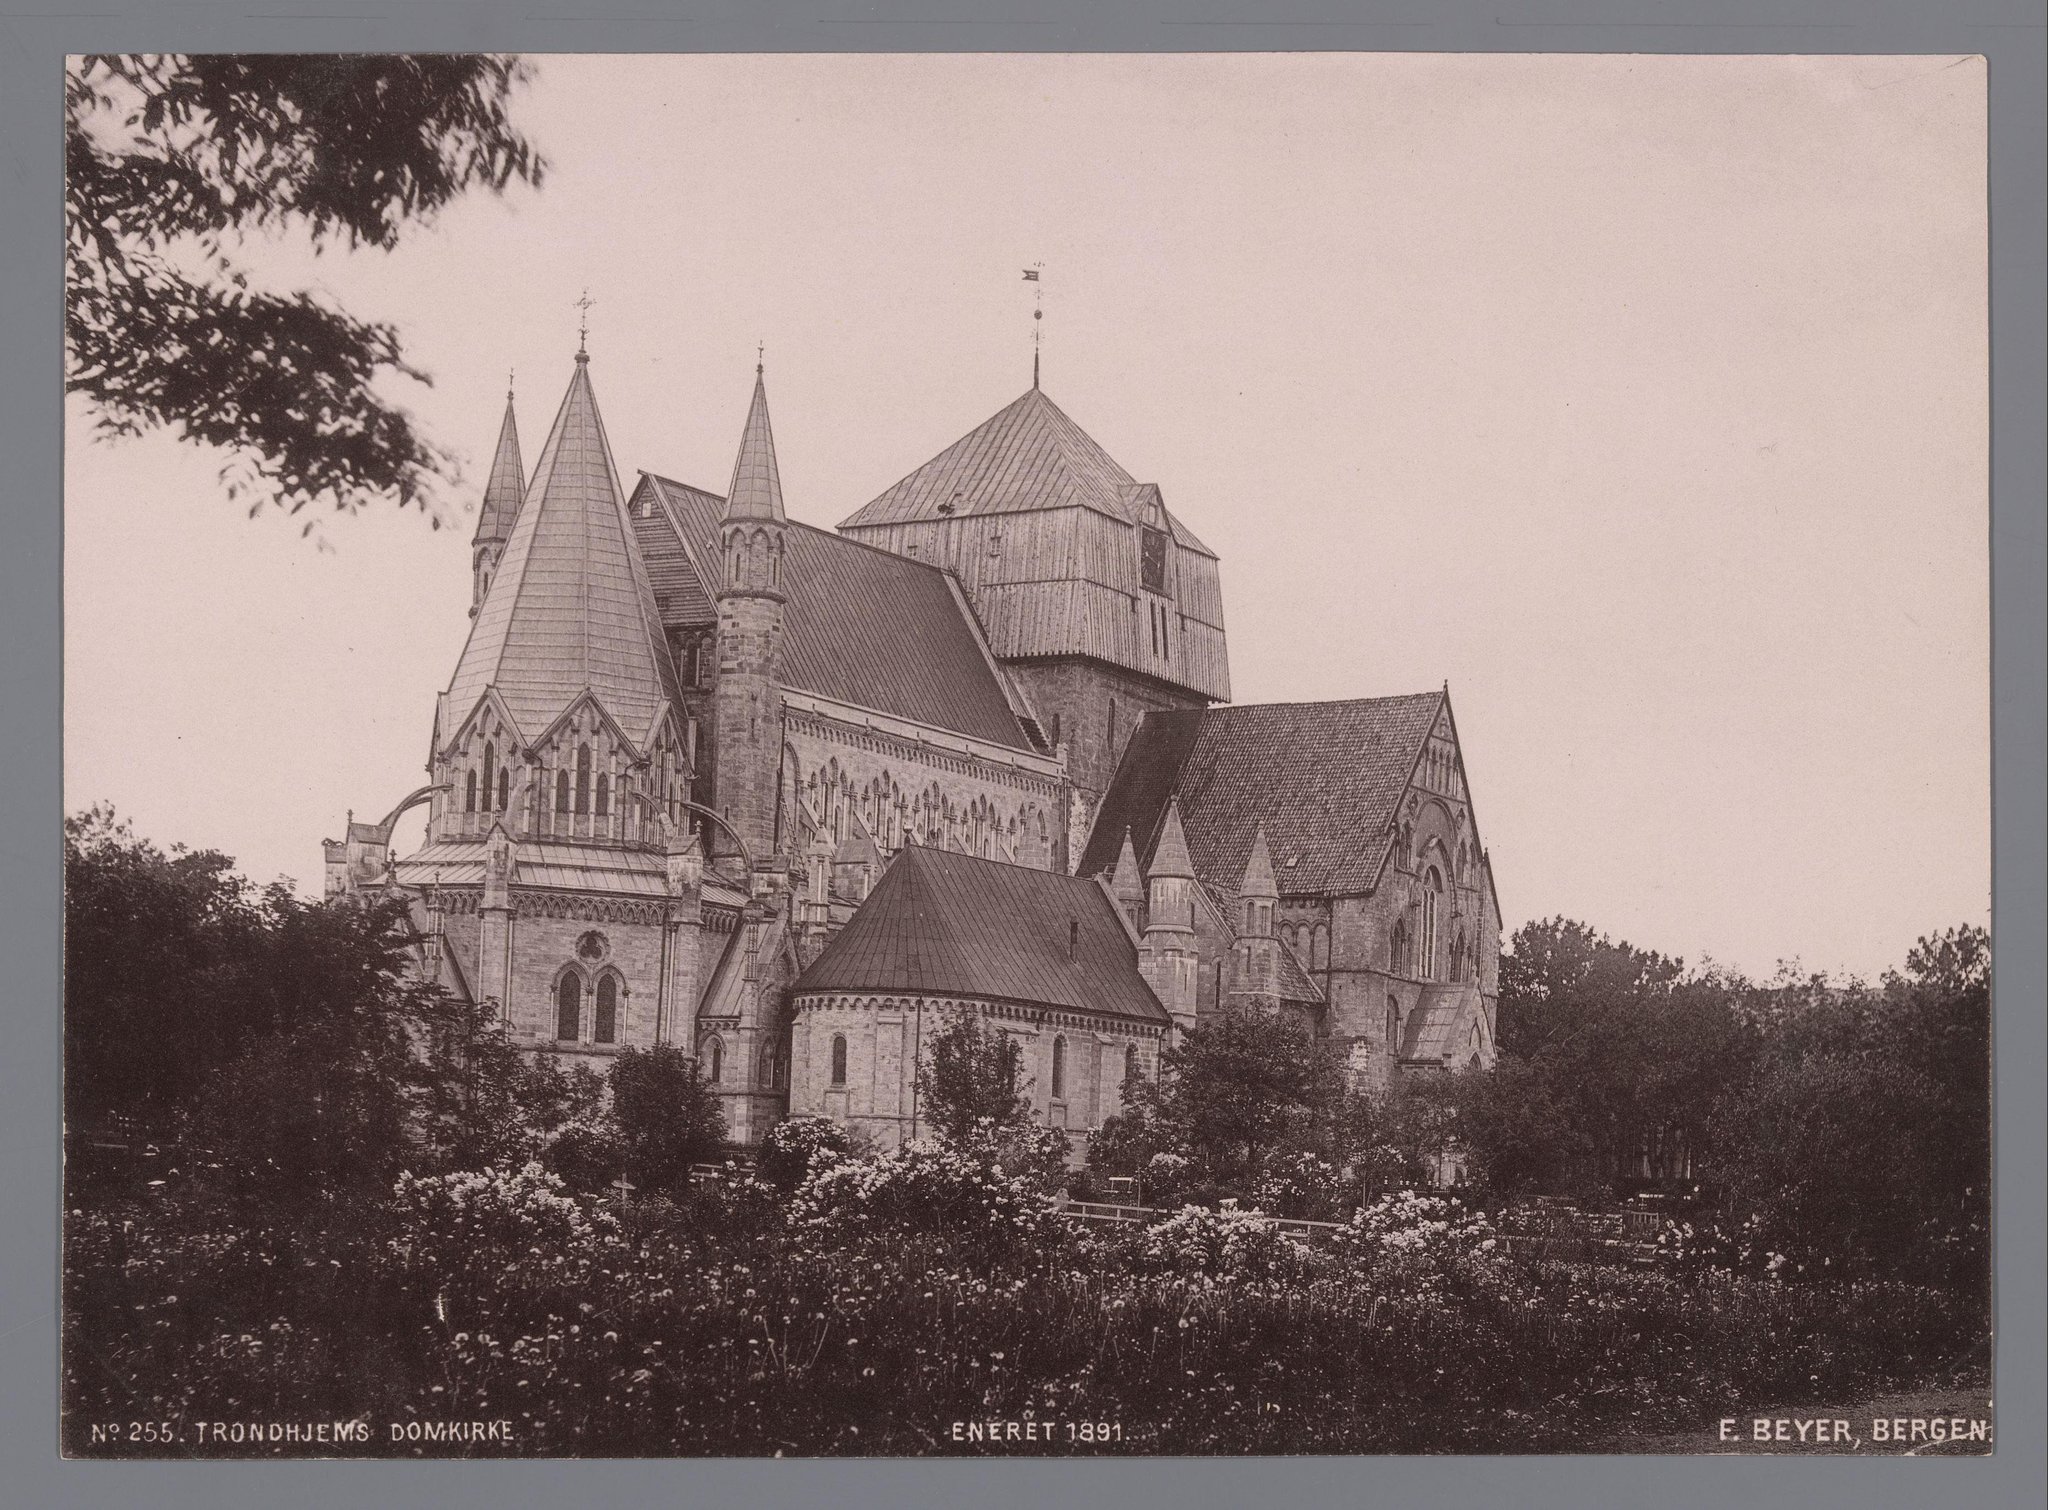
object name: photomechanical print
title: Trondhjems domkirke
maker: Anonymous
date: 1891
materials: paper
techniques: photograph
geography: bergen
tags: church (exterior)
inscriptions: number: ‘No 255.’, copyright notice: ‘ENERET 1891.’